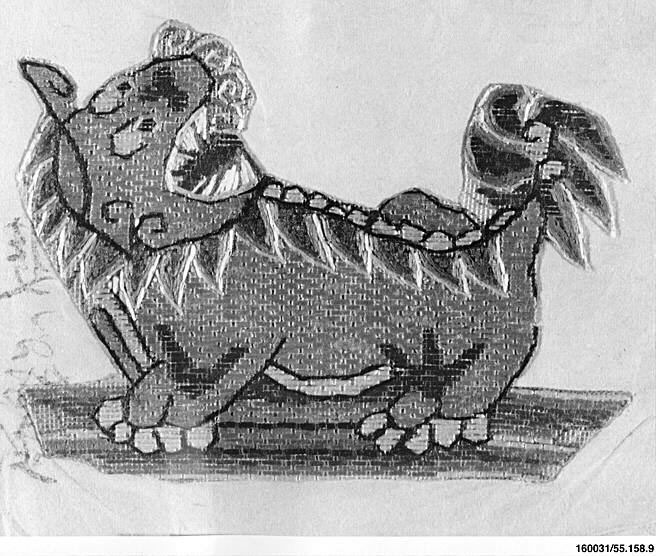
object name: appliqué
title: Applique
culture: chinese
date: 1867-1933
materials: silk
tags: animals